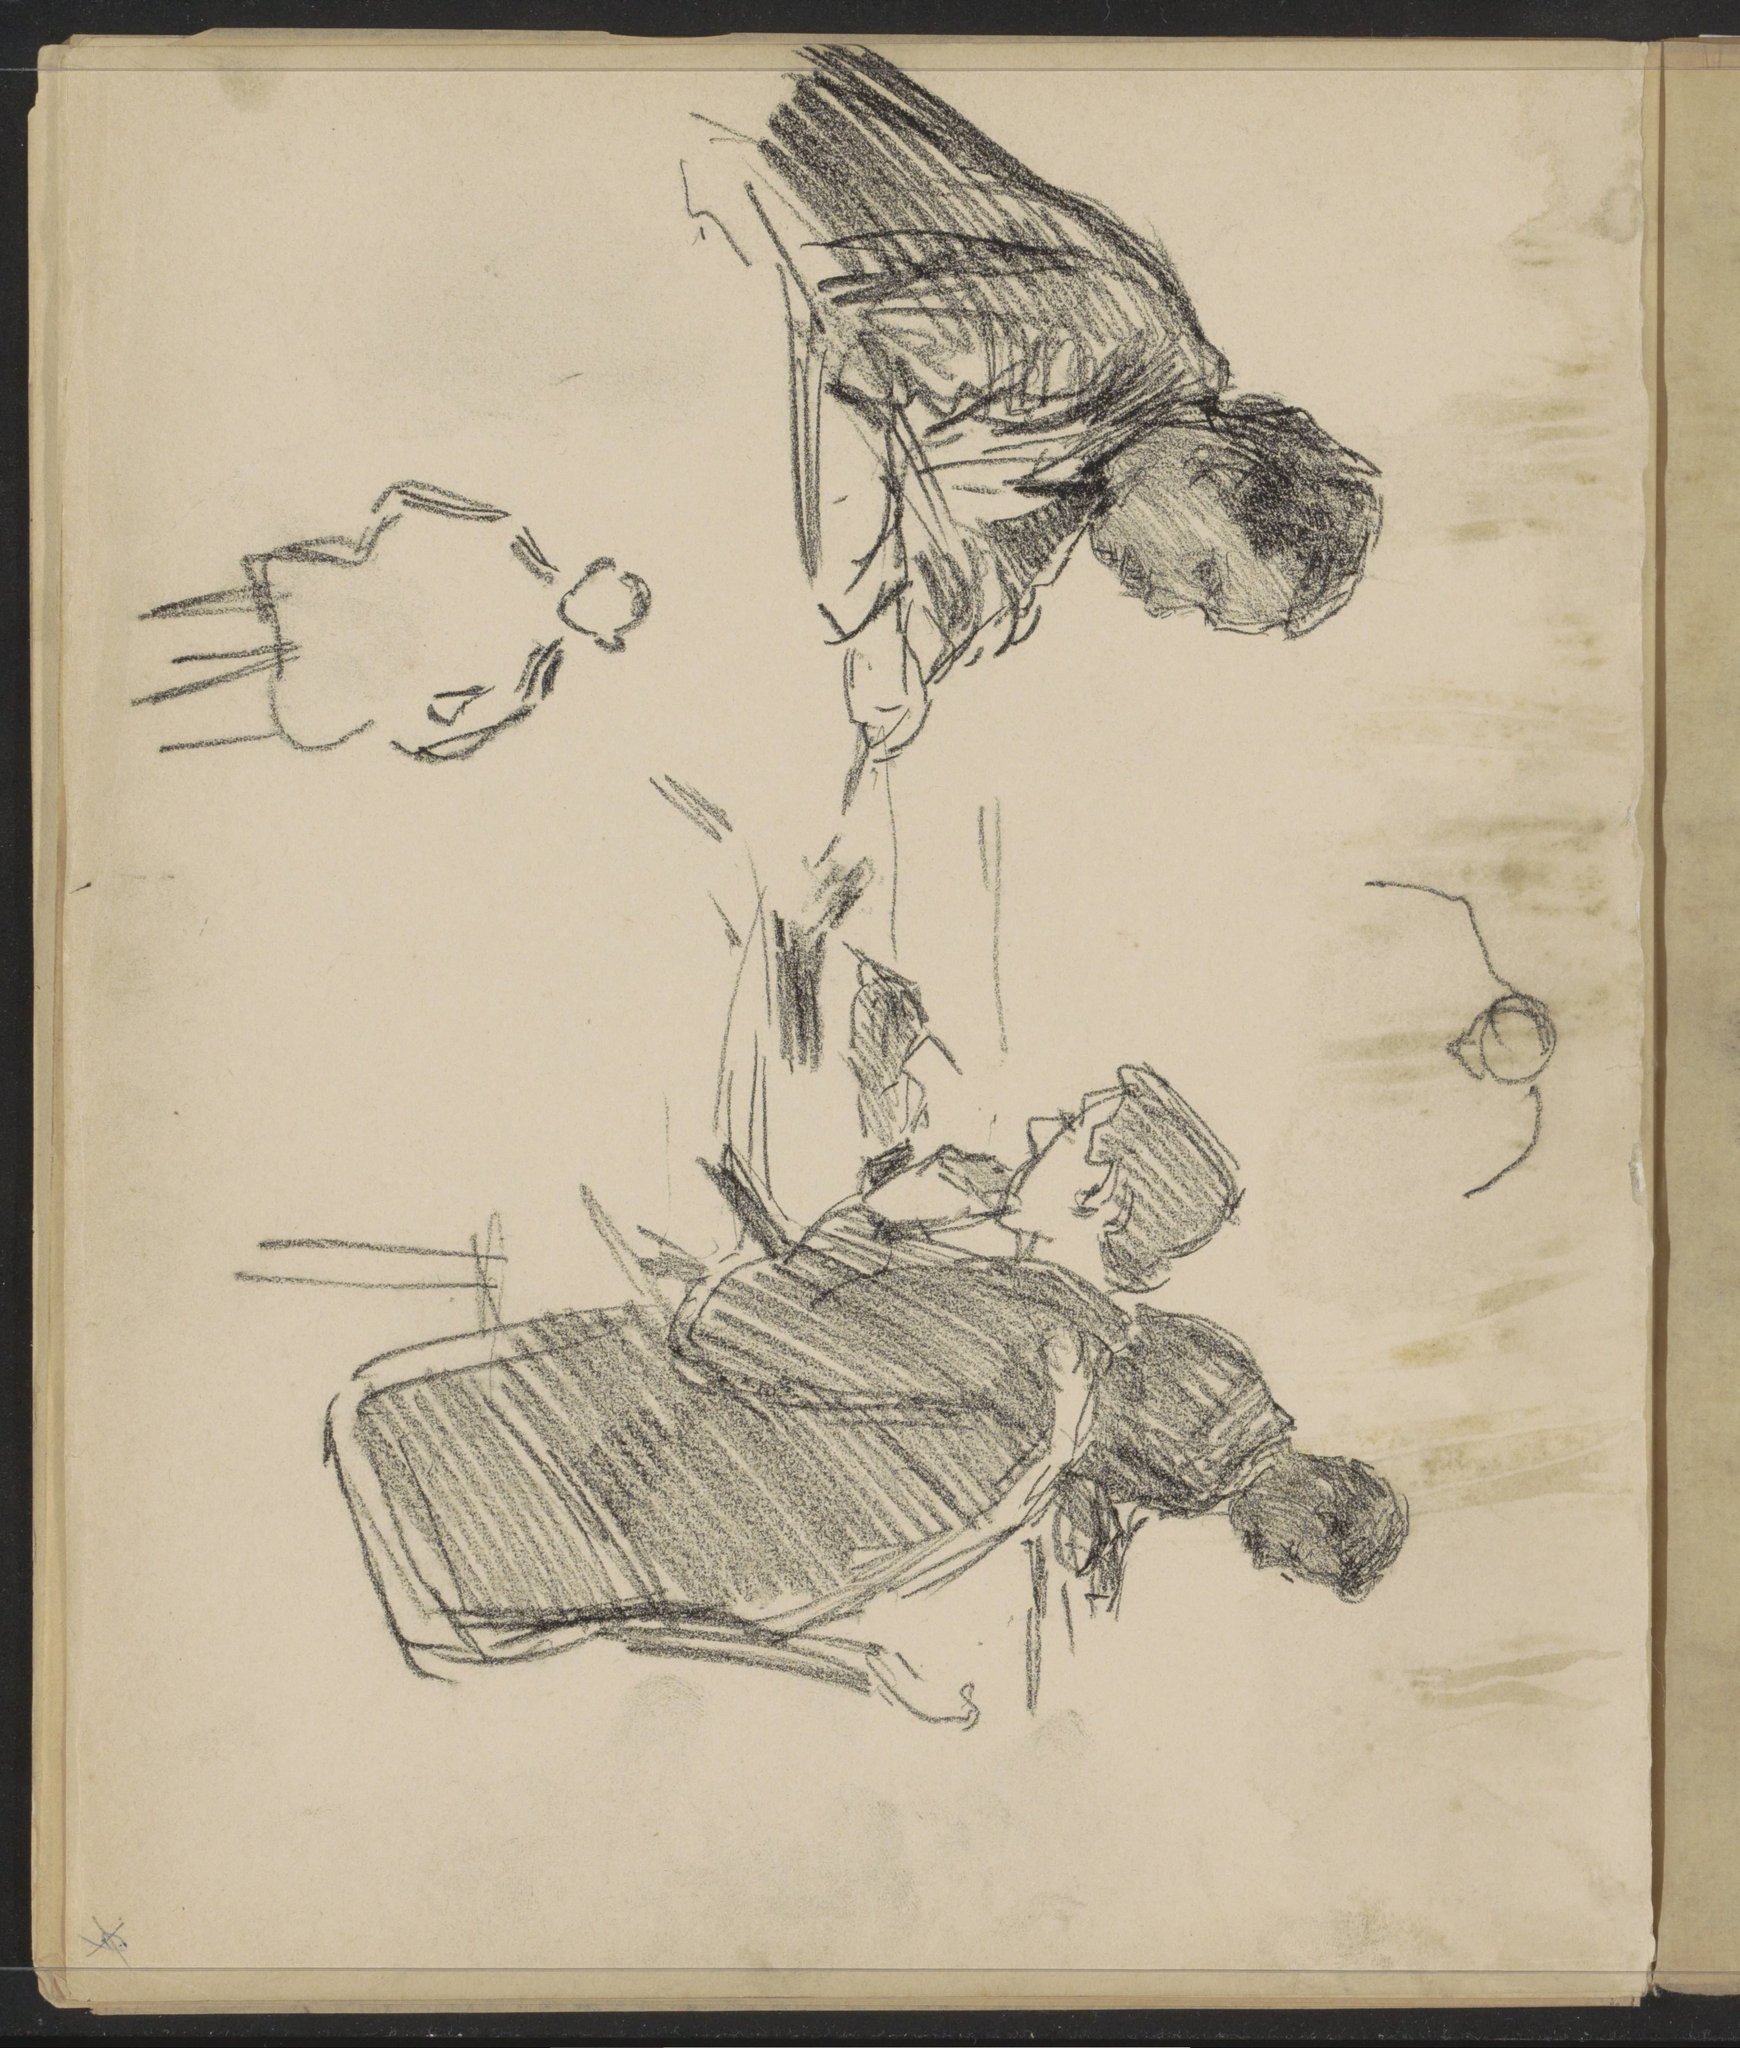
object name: sketchbook leaf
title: Schrijvende of tekenende mannen aan een tafel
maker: willem bastiaan tholen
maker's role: draughtsman, painter, print maker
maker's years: 1860-1931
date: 1890-1931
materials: chalk, paper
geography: the hague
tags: drawing, sitting figure, adult man, table, writing and letters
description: Mogelijk leerlingen van Tholen. Tevens een studie van een man met de armen in de zij. Blad 17 verso uit een schetsboek met 19 bladen.